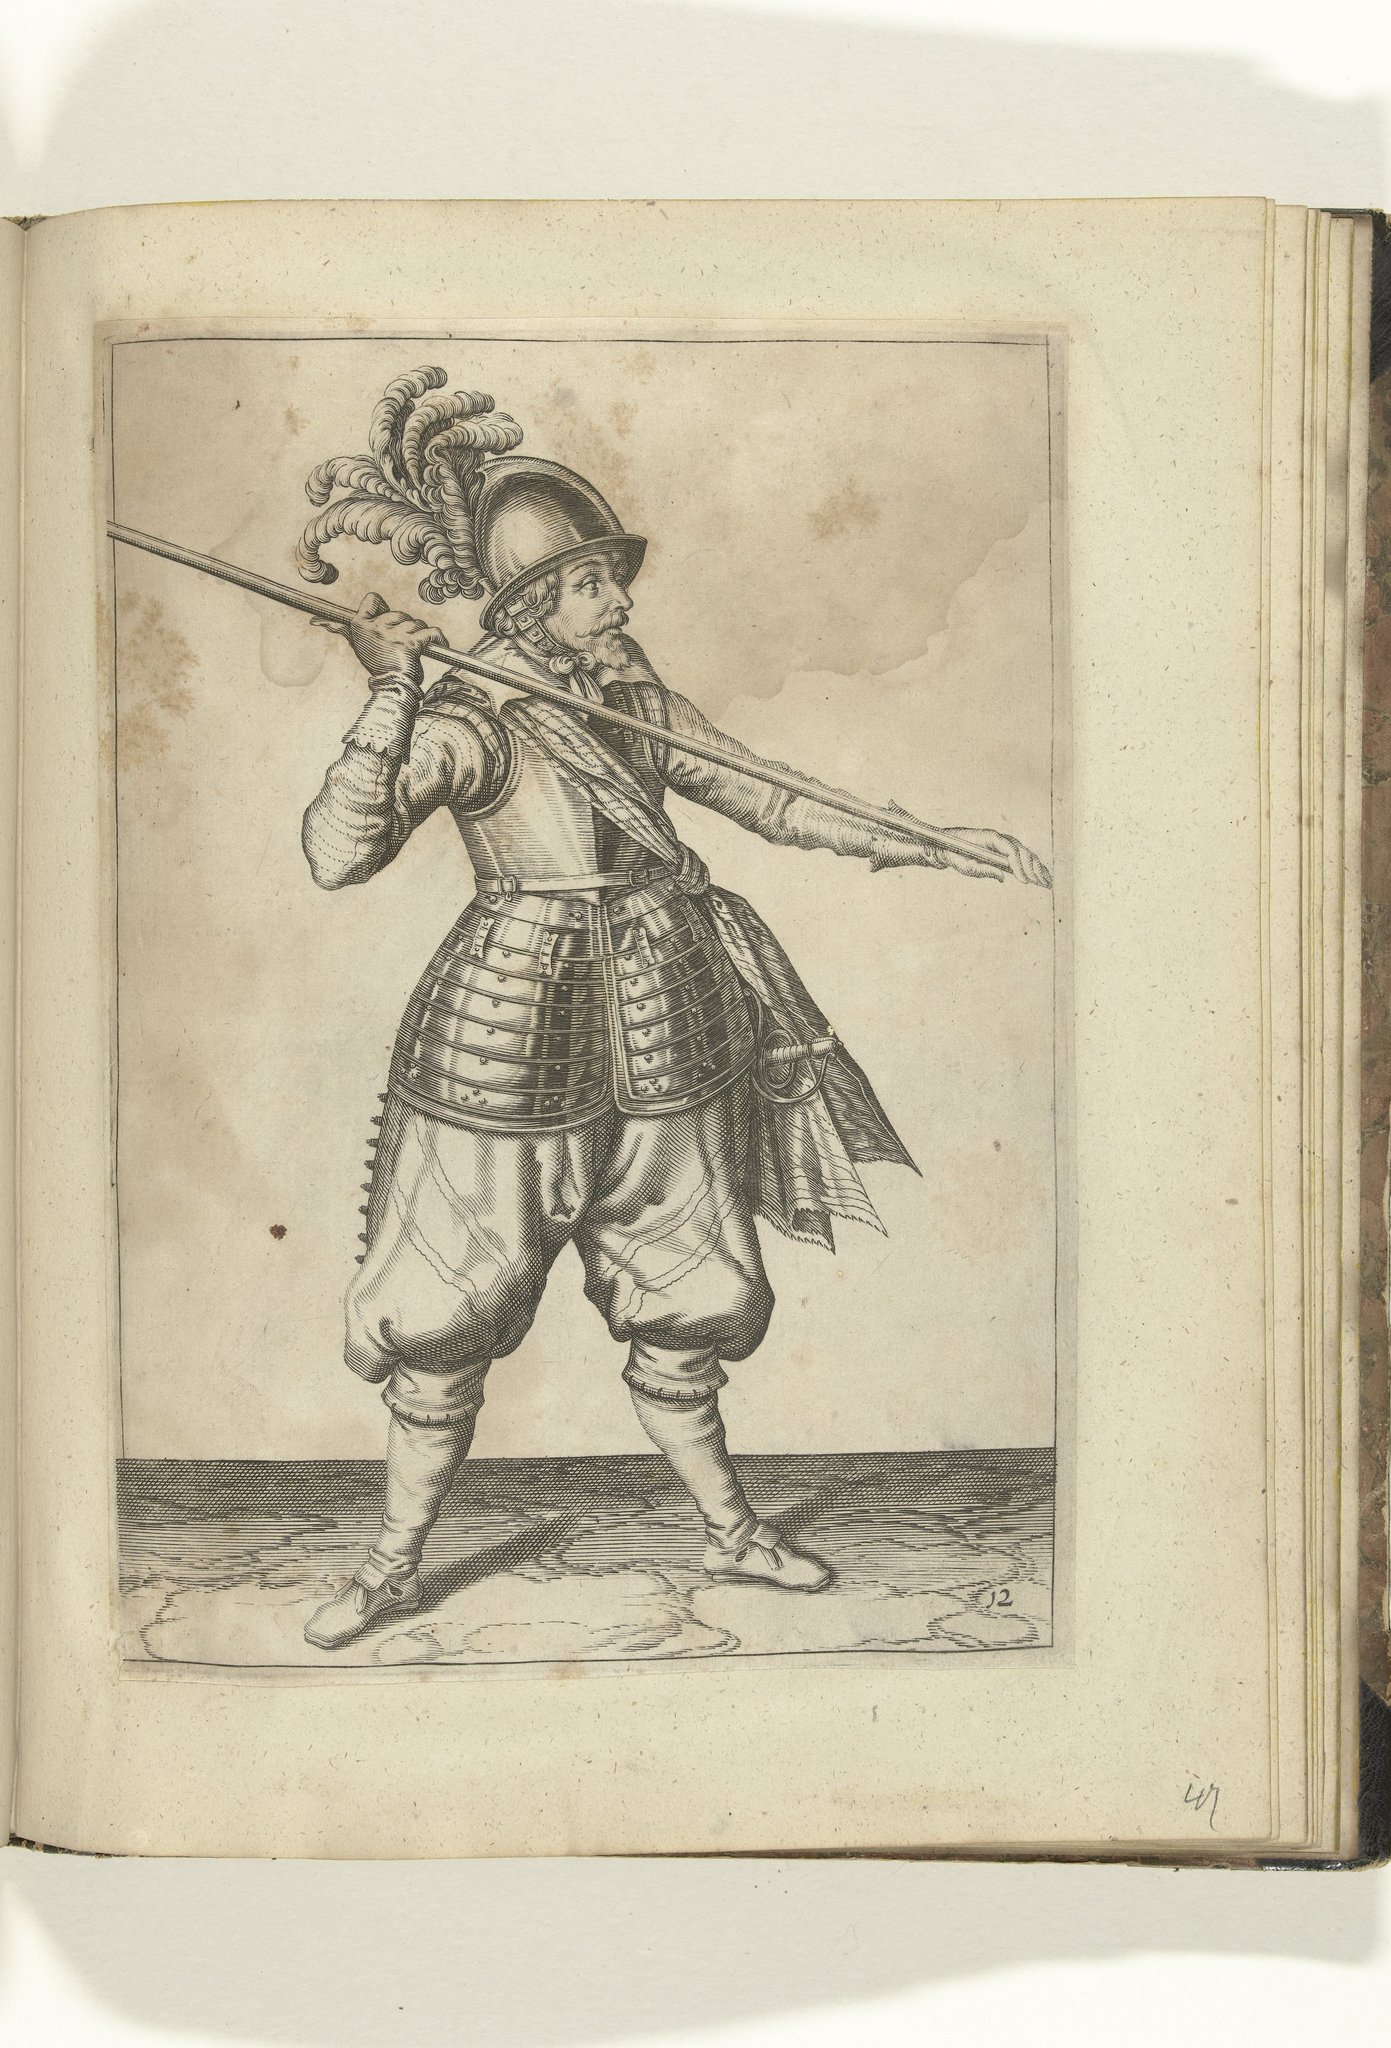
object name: print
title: Soldaat die zijn spies met beide handen ver uit elkaar boven zijn rechterschouder draagt, de punt schuin naar de grond gericht (nr. 12), ca. 1600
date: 1597-1608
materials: paper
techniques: engraving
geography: northern netherlands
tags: the hague, maurice (prince of orange), handling of weapons ~ military training, weapons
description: Een soldaat, ten voeten uit, die een spies (lans) boven zijn rechterschouder draagt, de punt schuin naar de grond gericht (nr. 12), ca. 1600. Zijn handen ver uit elkaar om de spies. Dit is de eerste handeling voor het laten zakken van de spies om onder een overwelving door te kunnen. Plaat 12 in de instructies voor het hanteren van de spies: Brief instruction upon the contrefaictinges, concerning the right use, of all what a Souldier needeth to know in handling of the Pike. Onderdeel van de illustraties in een Engelse editie van J. de Gheyns Wapenhandelinghe: J. de Gheyn, The exercise of armes for calivres, muskettes and pikes after the ordre of Maurits Prince of Orange, 's-Gravenhage 1608. Krijgswezen rond 1600.